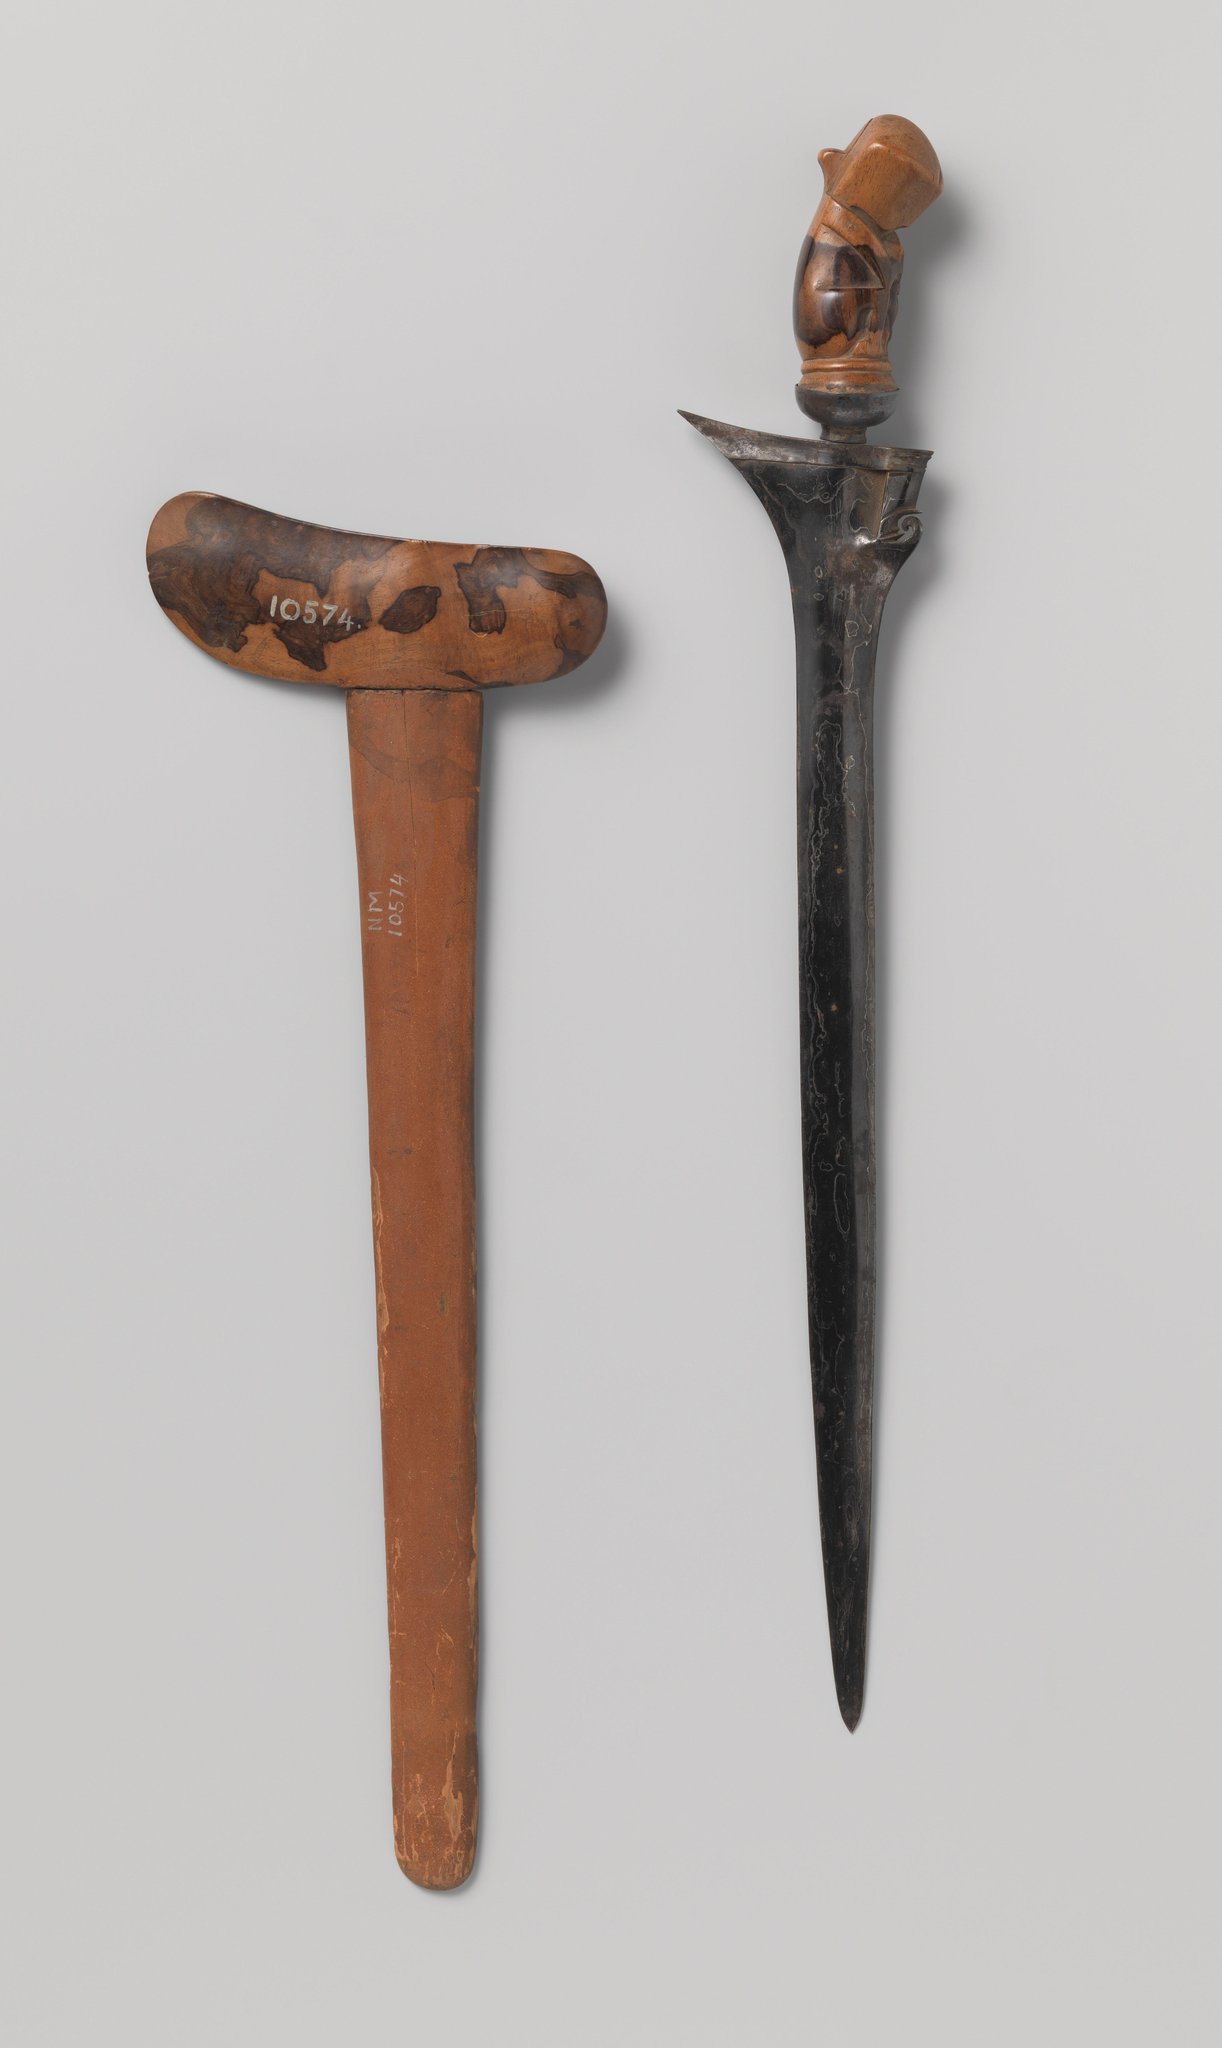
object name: kris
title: Kris van Bali met schede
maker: Anonymous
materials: iron, silver, wood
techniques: metalworking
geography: bali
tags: lombok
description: Kris van Bali met zwart gedamaskeerd lemmet met zilveren vlammen, met rijk gesneden met zilver gemonteerd gevest. Van de schede is slechts de helft aanwezig. Buitgemaakt op de expeditie van Lombok in 1894.